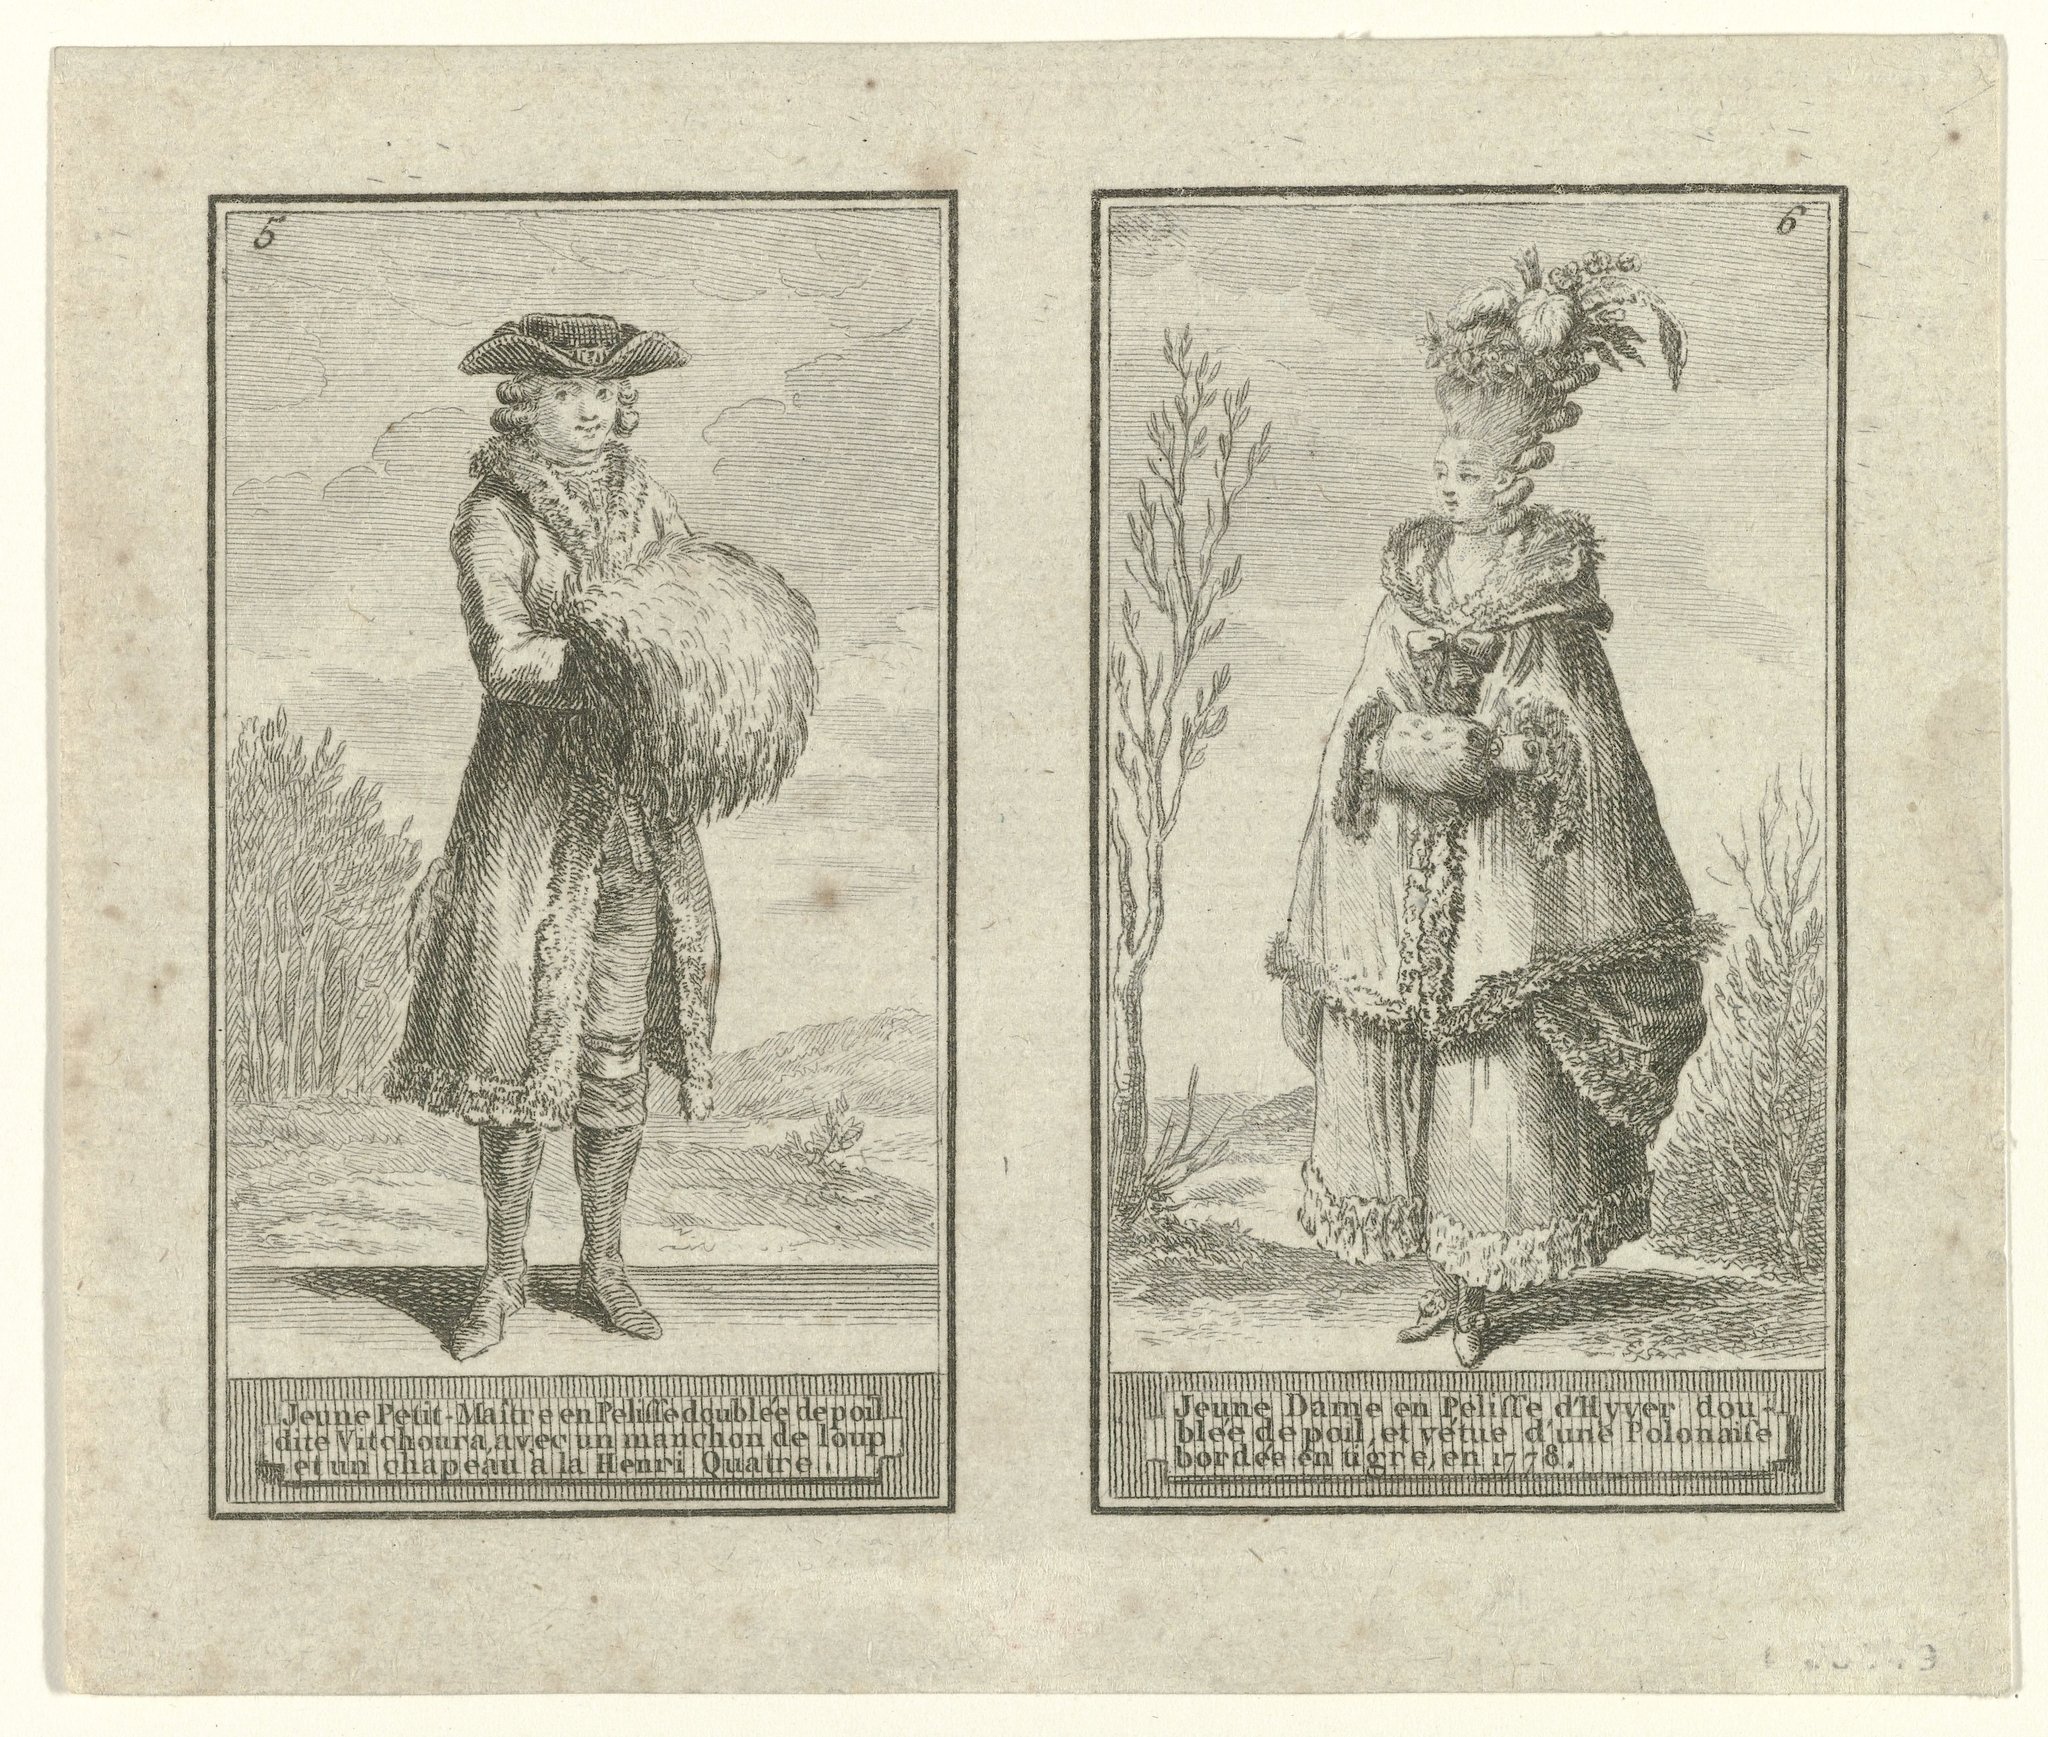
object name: fashion print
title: Jeune Petit-Maître en peliss (...)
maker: Anonymous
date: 1778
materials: paper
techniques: etching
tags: calendar, almanac, dandy, beau, cape (pelisse) (+ women's clothes), coat (pelisse) (+ men's clothes), cape (pelisse) (+ fur used for clothes), head-gear (+ women's clothes), head-gear: hat (+ men's clothes), styles of hairdress - aa - ~ women, fashion plates, muff (+ fur used for clothes), muff (+ women's clothes), dress, gown: robe à la polonaise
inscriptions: inscription: ‘Jeune Dame en Pelisse d'Hyver doublée de poul, et vétue d'une polonaise bordée en tigre, en 1778.’, inscription: ‘Jeune Petit-Maître en pelisse doublée depoil dite Vitchoura avec une manchon de loup et un chapeau a la Henri Quatre.’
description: Twee kaders, met onderaan een plaquette. Jonge Petit-Maître gekleed in een pelisse gevoerd met bont genaamd Vitchoura. De handen in een grote mof van wolvenbont. Op het hoofd een hoed: chapeau à la Henri Quatre. Jonge vrouw gekleed in robe à la polonaise en een pelisse voor de winter met capuchon en gevoerd met bont. De handen in een kleine mof. De prent maakt waarschijnlijk deel uit van een almanak, ca. 1778